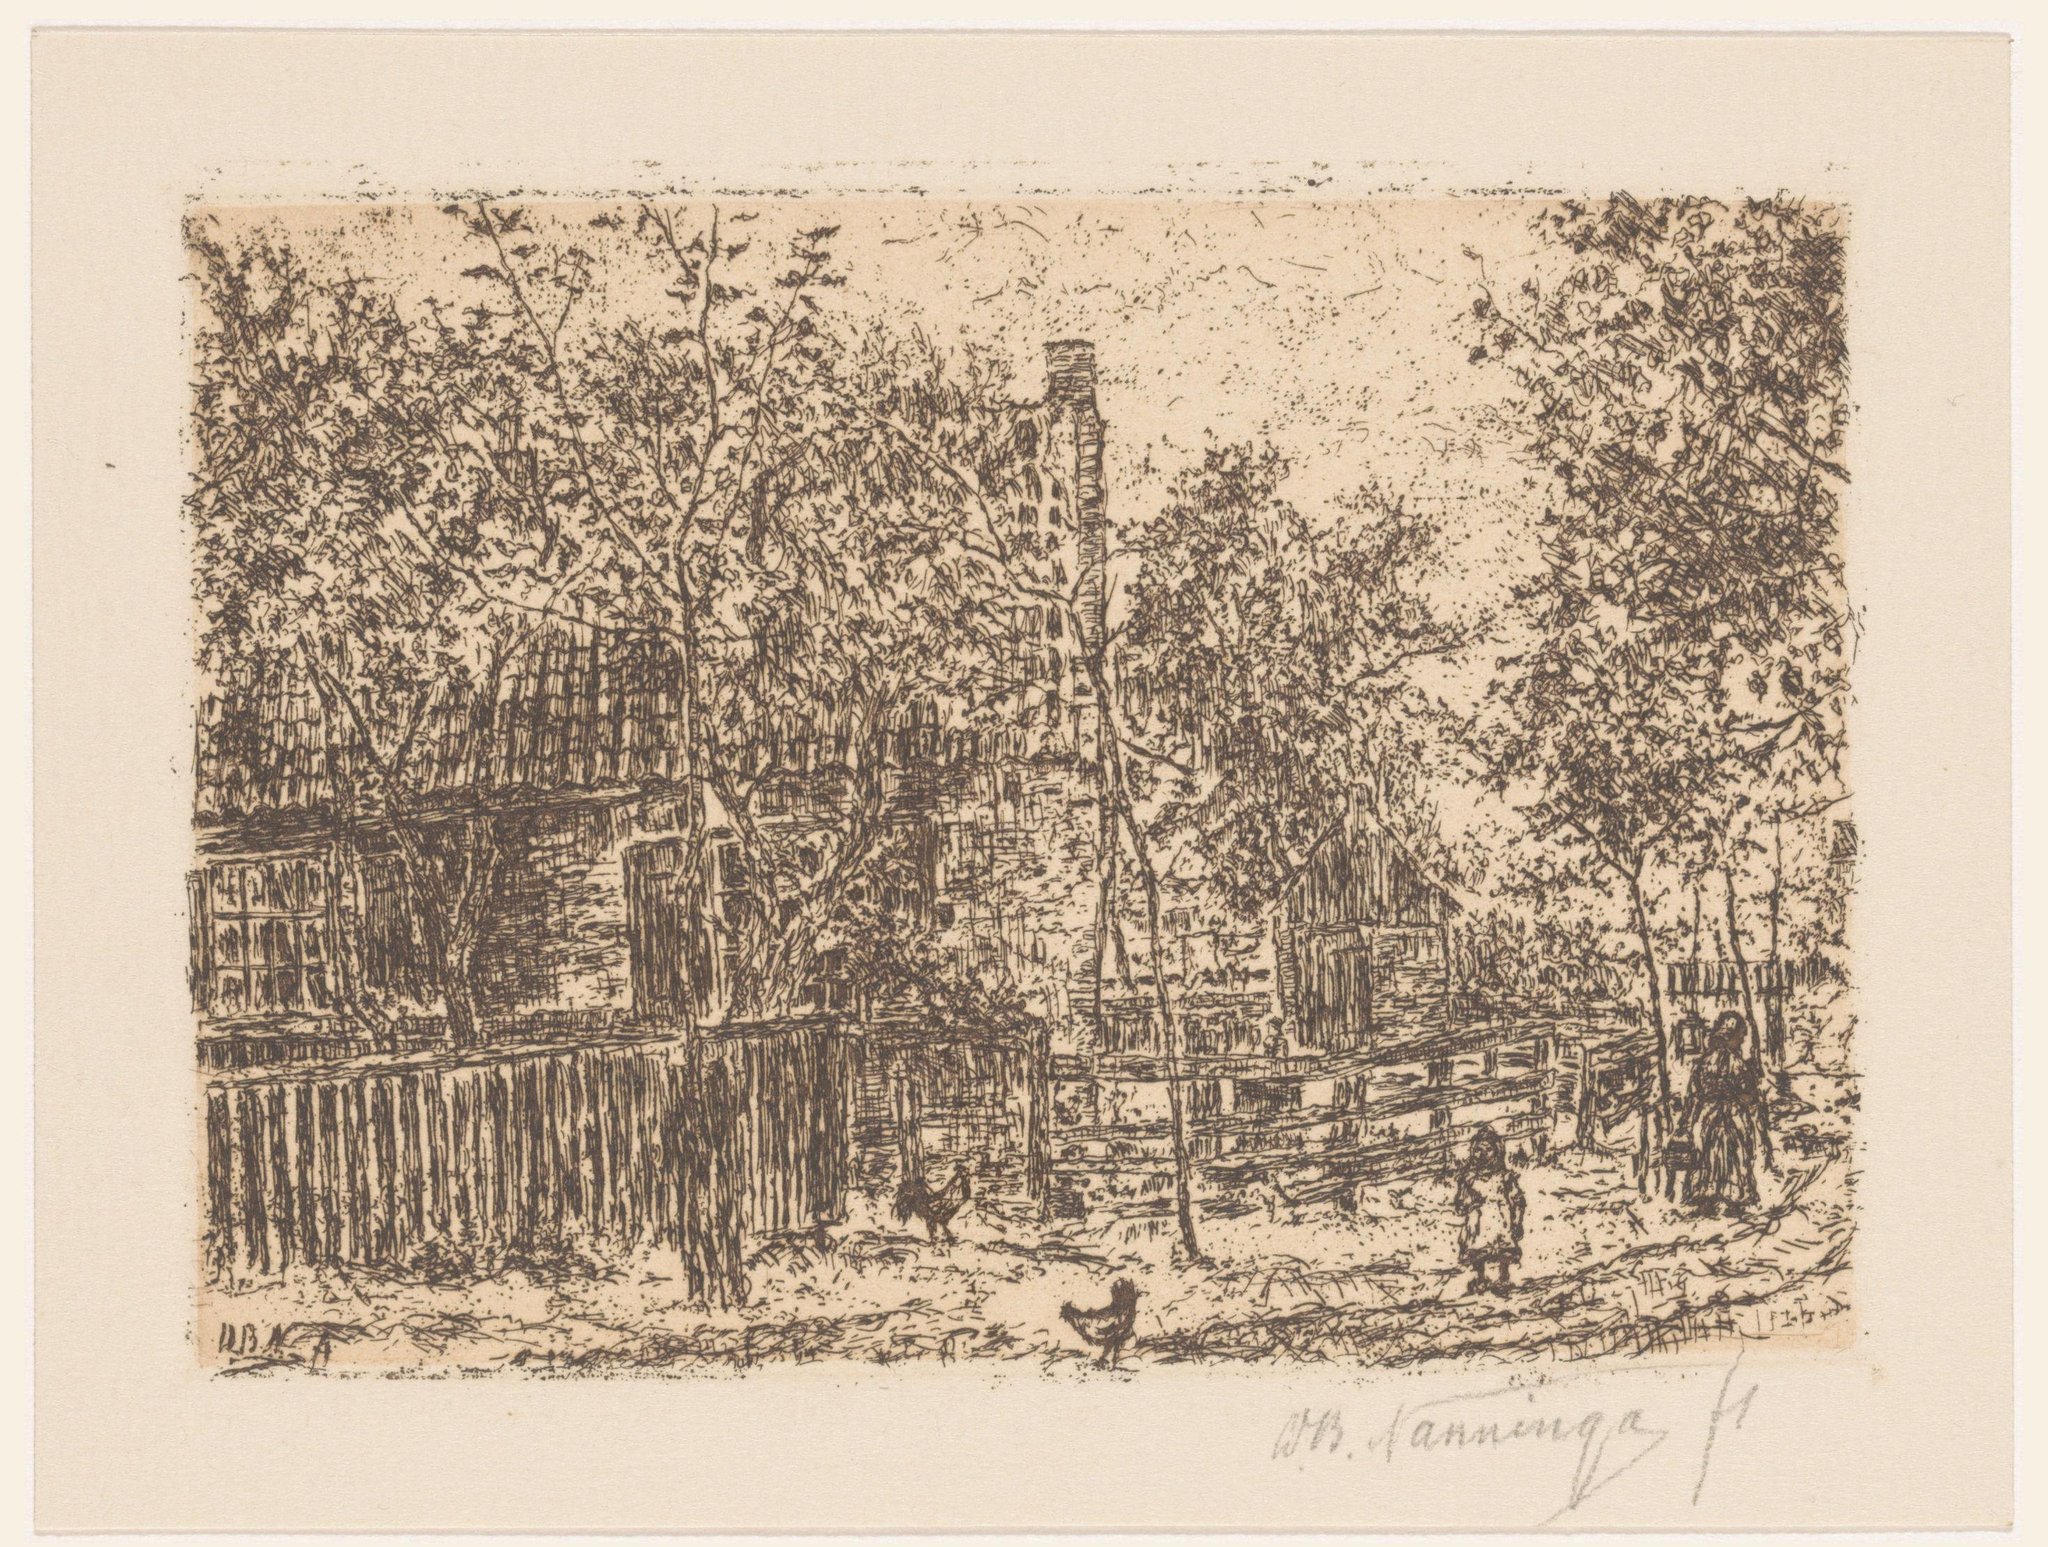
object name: print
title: Dorpsgezicht met kippen op de weg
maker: dirk berend nanninga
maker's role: print maker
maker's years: 1868-1954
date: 1878-1931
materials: paper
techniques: etching, intaglio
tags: village, public road in village, fowl (cock, hen, chicken, etc.)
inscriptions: collector's mark: Lugt 2228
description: Vooraan lopen twee kippen, een kind en een vrouw over de weg. Erachter huizen en bomen.